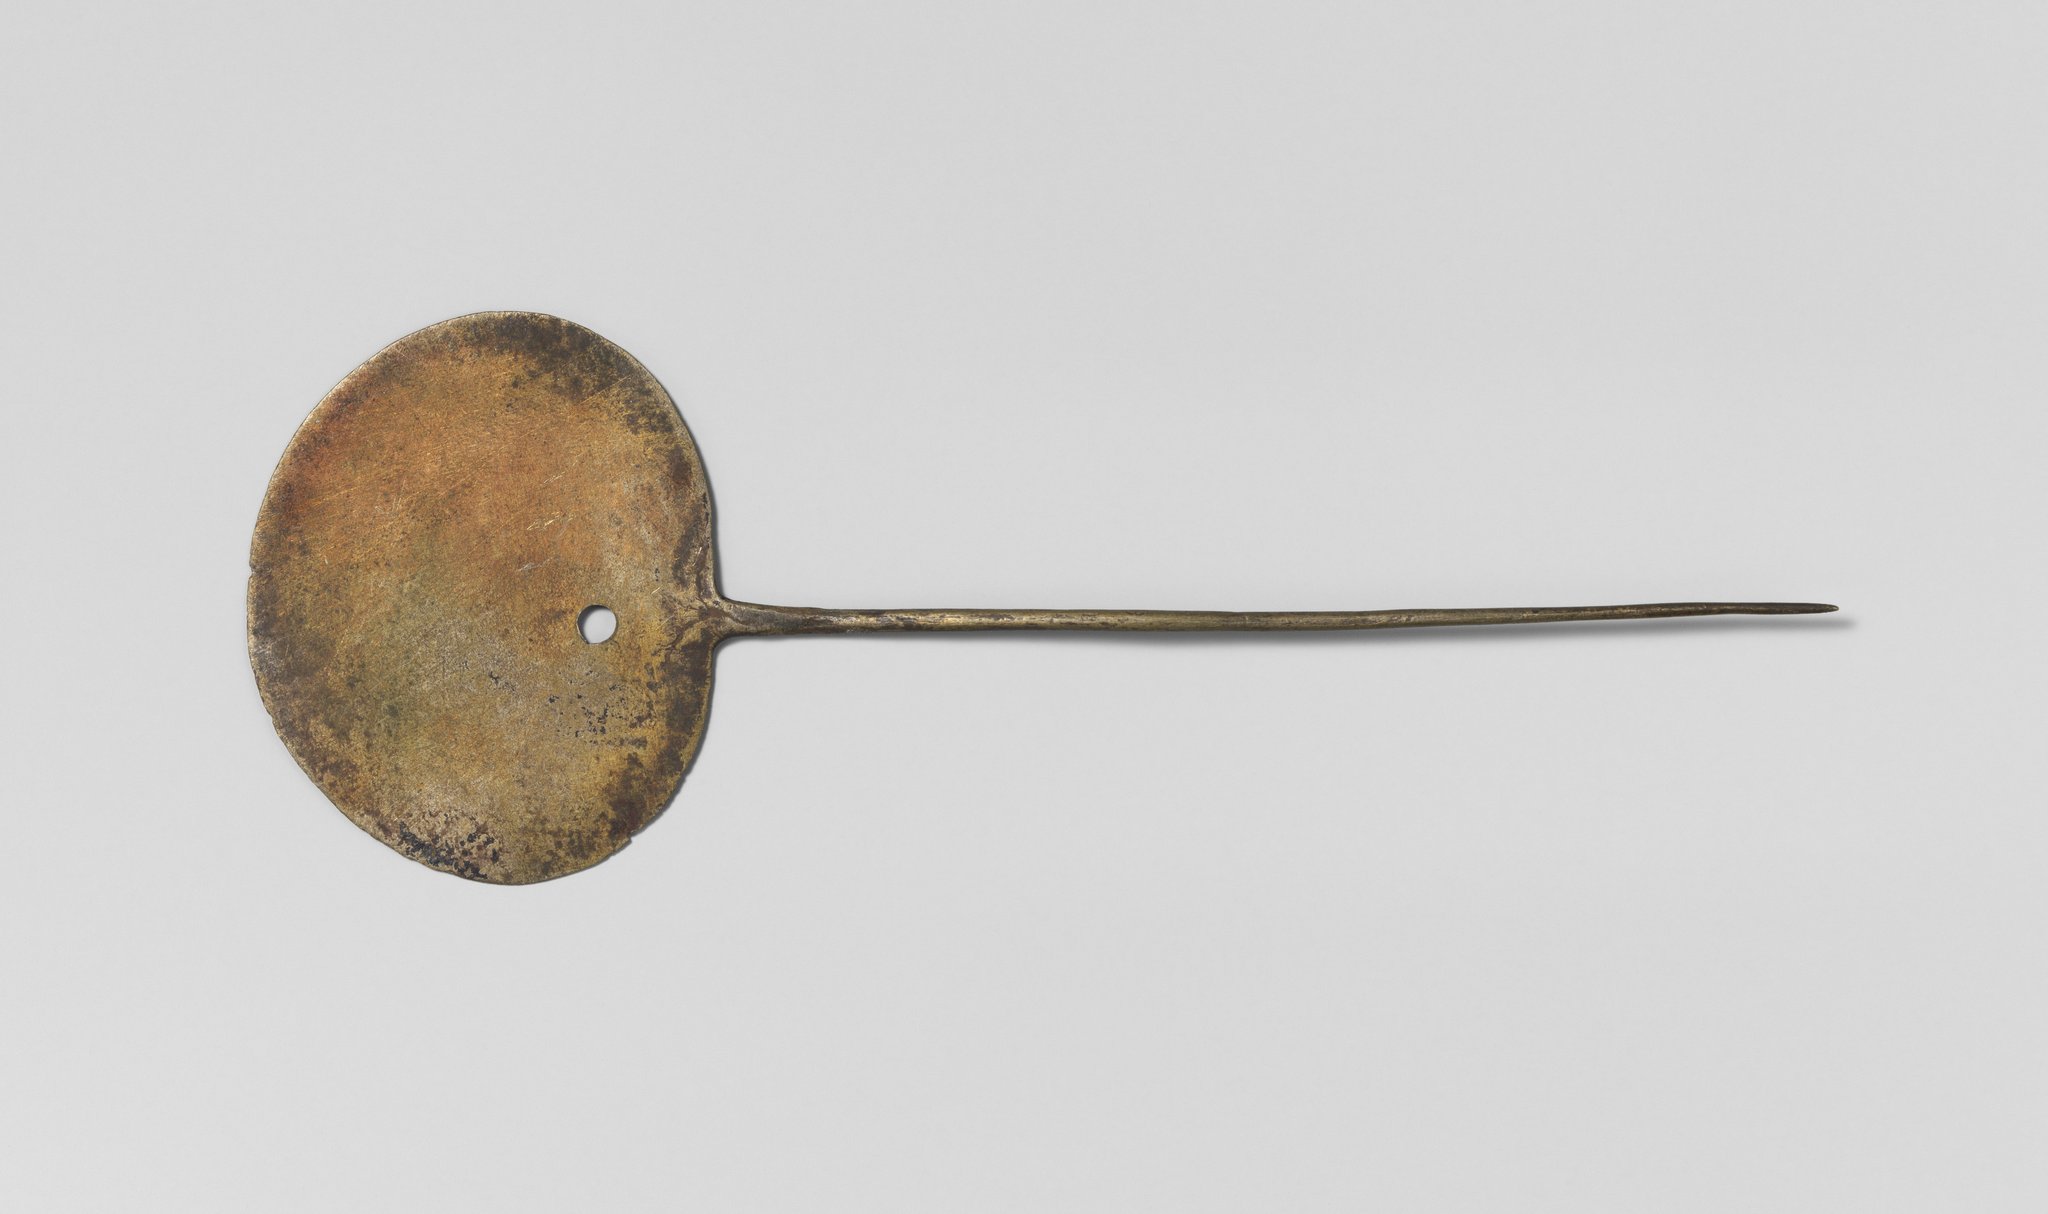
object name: pin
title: Tupu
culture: inca or wari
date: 1601-1700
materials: silver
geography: ecuador, peru, bolivia, argentina, or chile